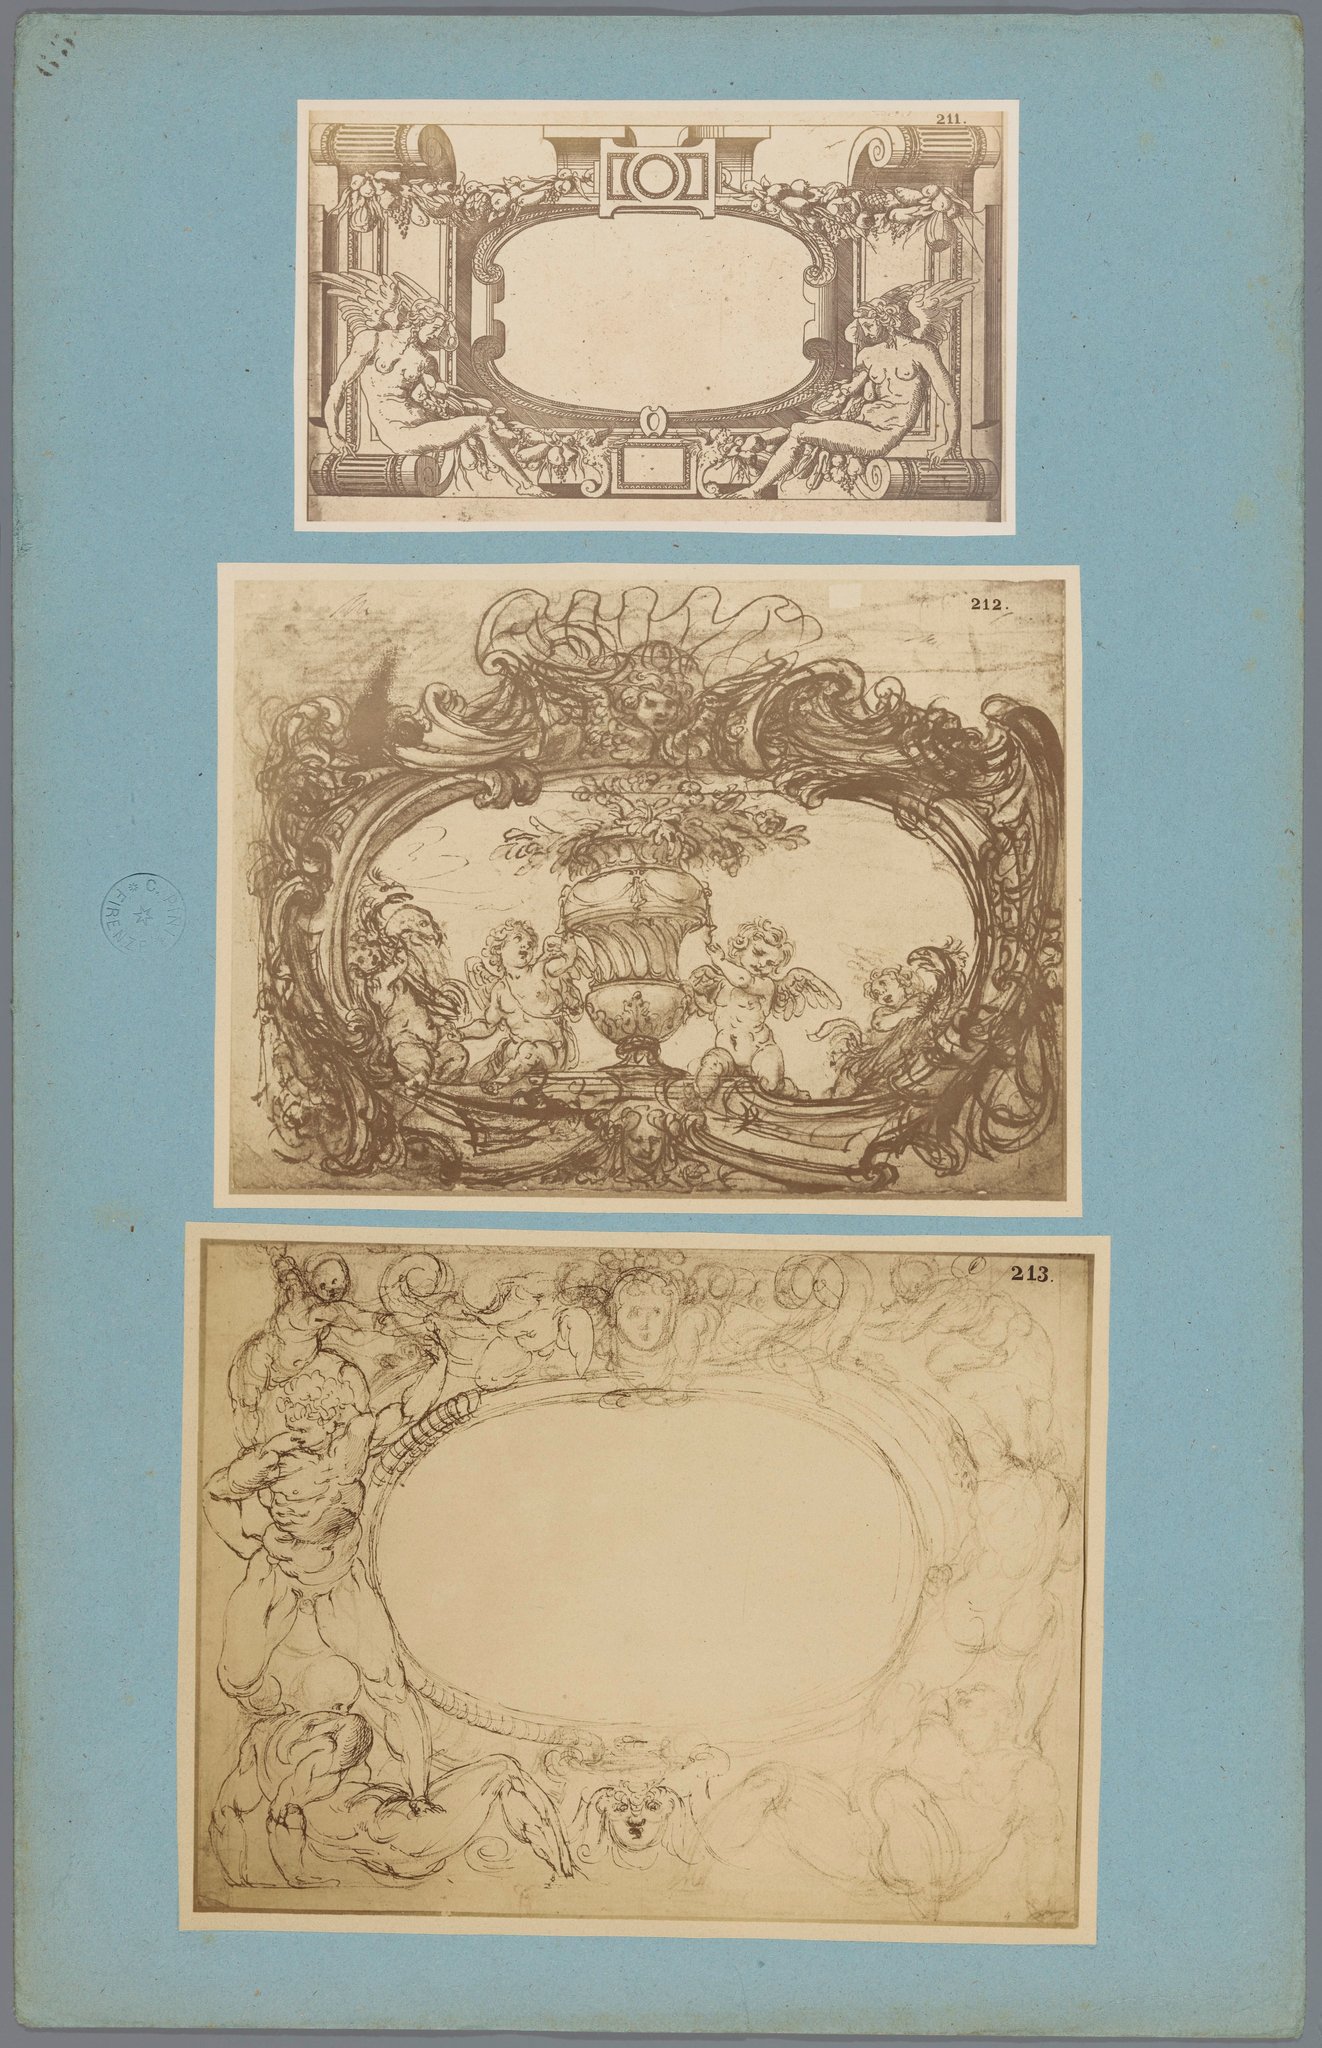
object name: reproduction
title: Drie fotoreproducties van afbeeldingen van cartouches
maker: Anonymous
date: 1875-1900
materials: cardboard, photographic support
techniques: albumen print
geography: europe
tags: drawing, sketch, ornament ~ cartouche, fruits, cupids: 'amores', 'amoretti', 'putti', garden vase, europe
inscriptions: collector's mark: Lugt 3937, number: ‘212.’, number: ‘211.’, number: ‘63’, name: ‘C. Pini Firenze’, number: ‘213.’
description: Boven (211) een prent van een cartouche gedecoreerd met engelen en fruit, midden (212) een tekening van een cartouche gedecoreerd met putti en een vaas, onder (213) een tekening van een cartouche omringd door mannenfigureren.